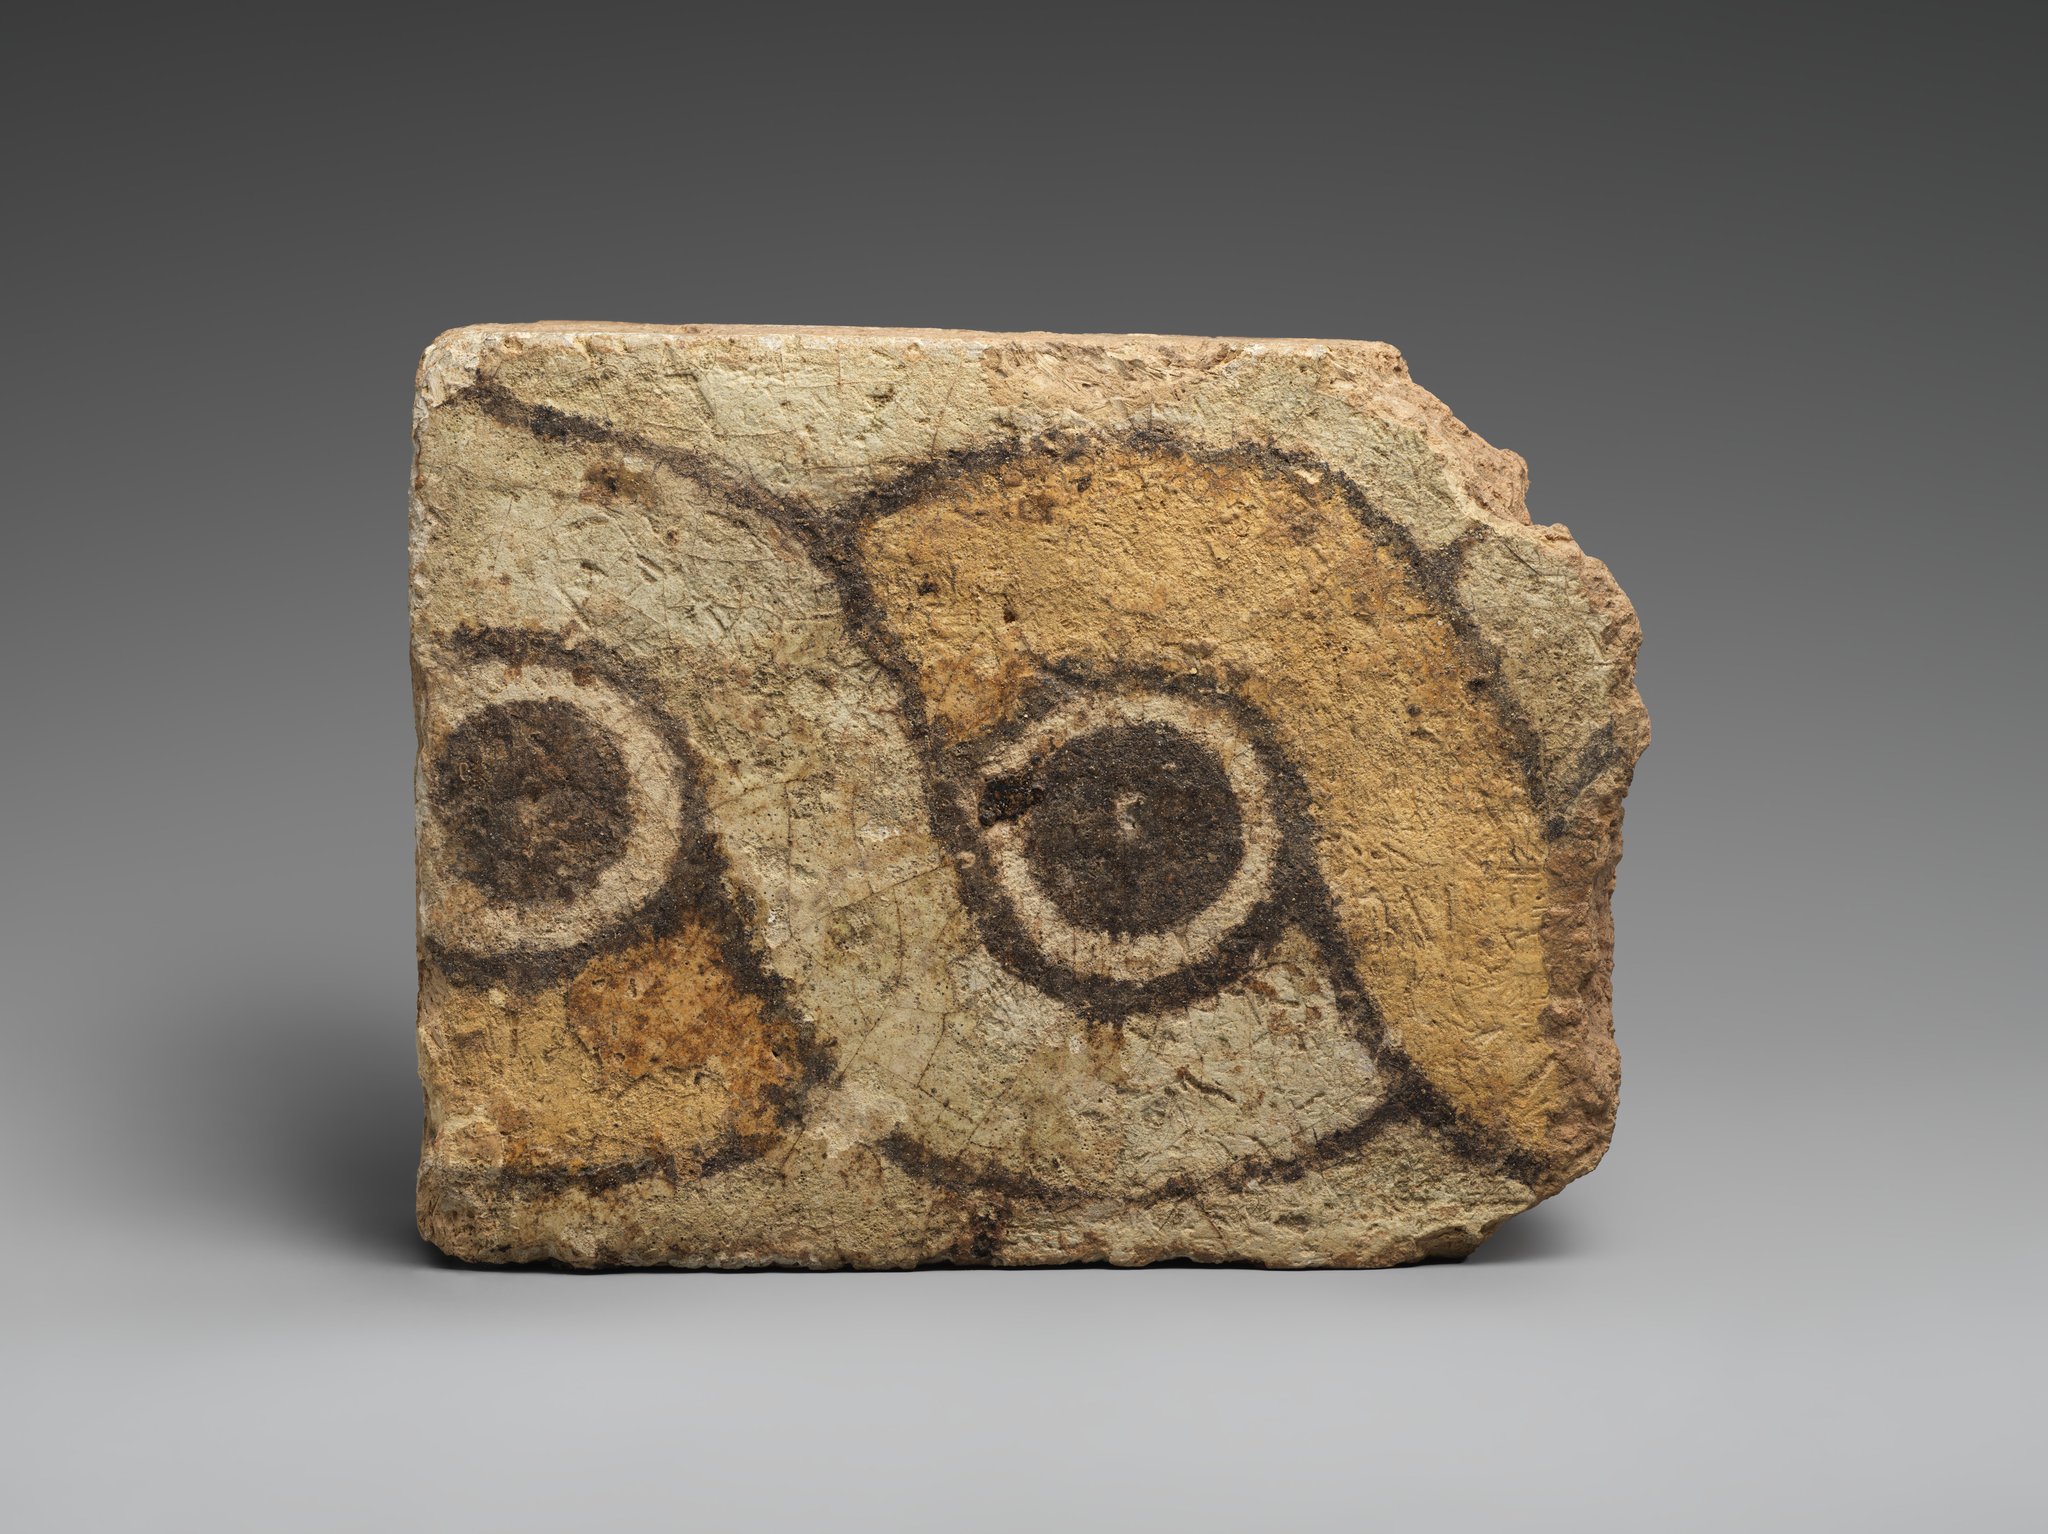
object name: brick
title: Brick fragment with a guilloche design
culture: assyrian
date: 900-801 BCE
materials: ceramic, glaze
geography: mesopotamia